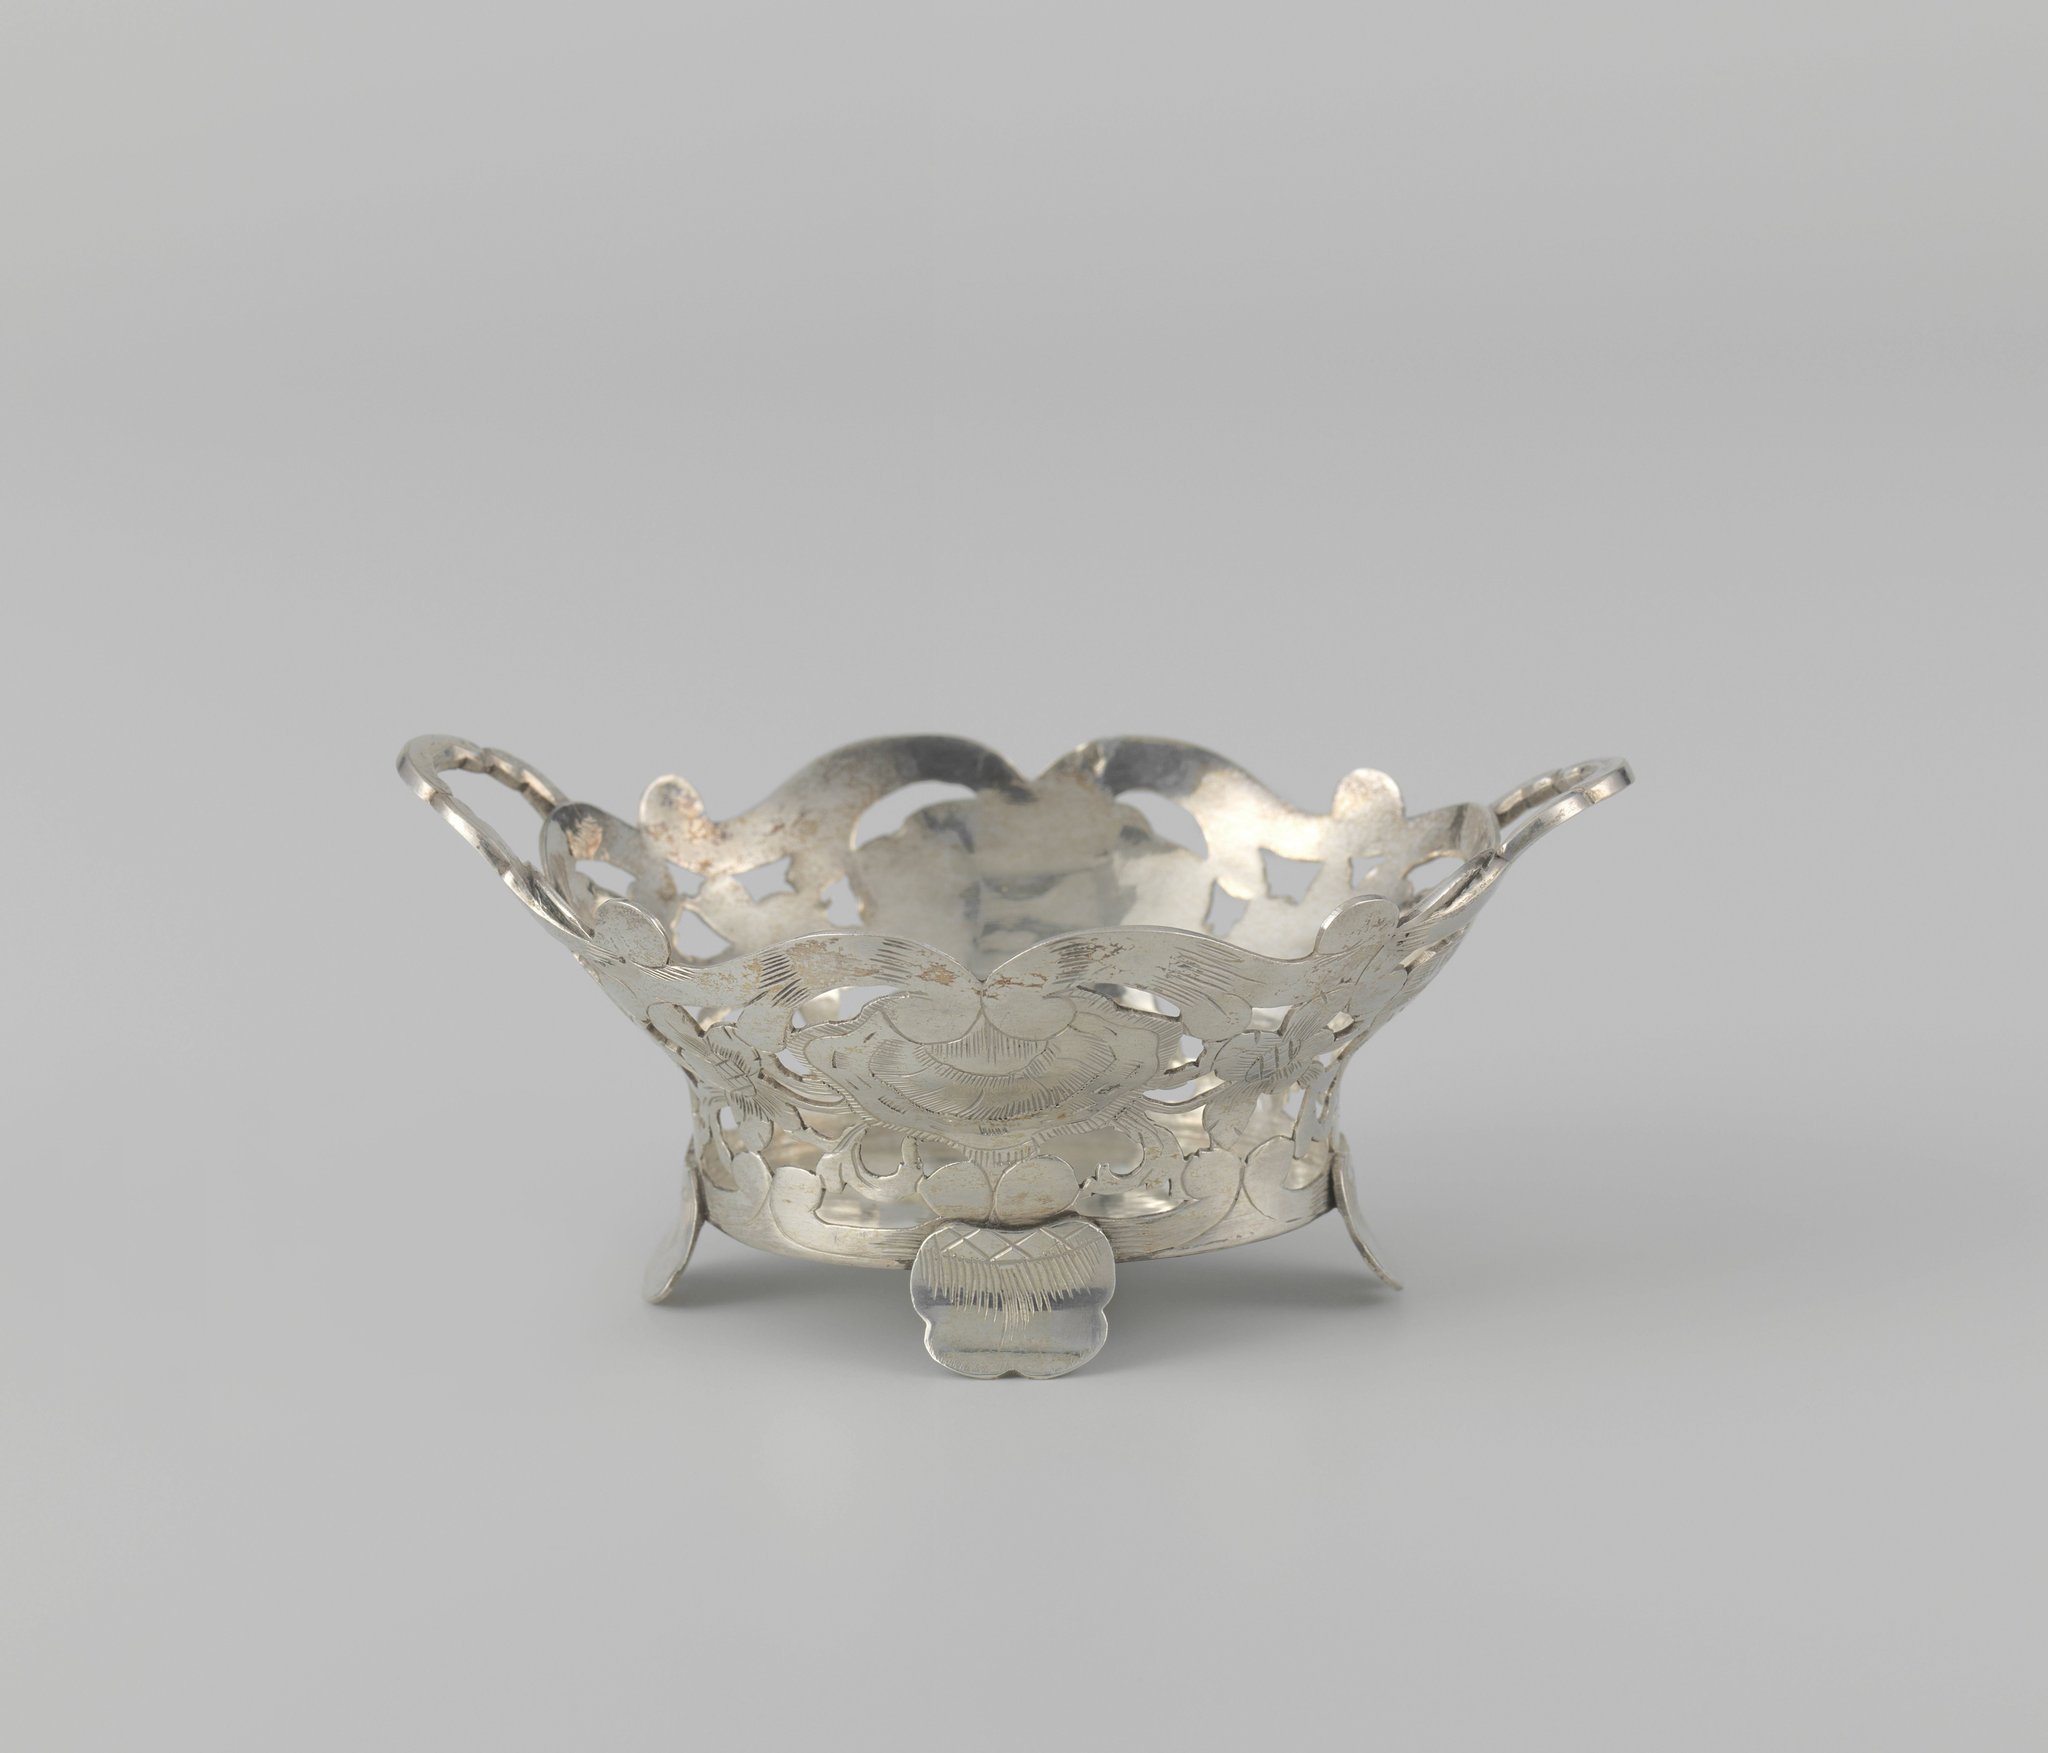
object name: miniature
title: Broodmand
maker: jan bonket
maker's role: silversmith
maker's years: 1727-1789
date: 1771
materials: silver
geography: amsterdam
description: Opengewerkte broodmand op vier poten. De broodmand heeft twee handvatten en is aan de buitenzijde gegraveerd met bloemen. De broodmand is gemerkt: stk.= Amsterdam, jrl.= M (1771), mt.= Jan Bonket.